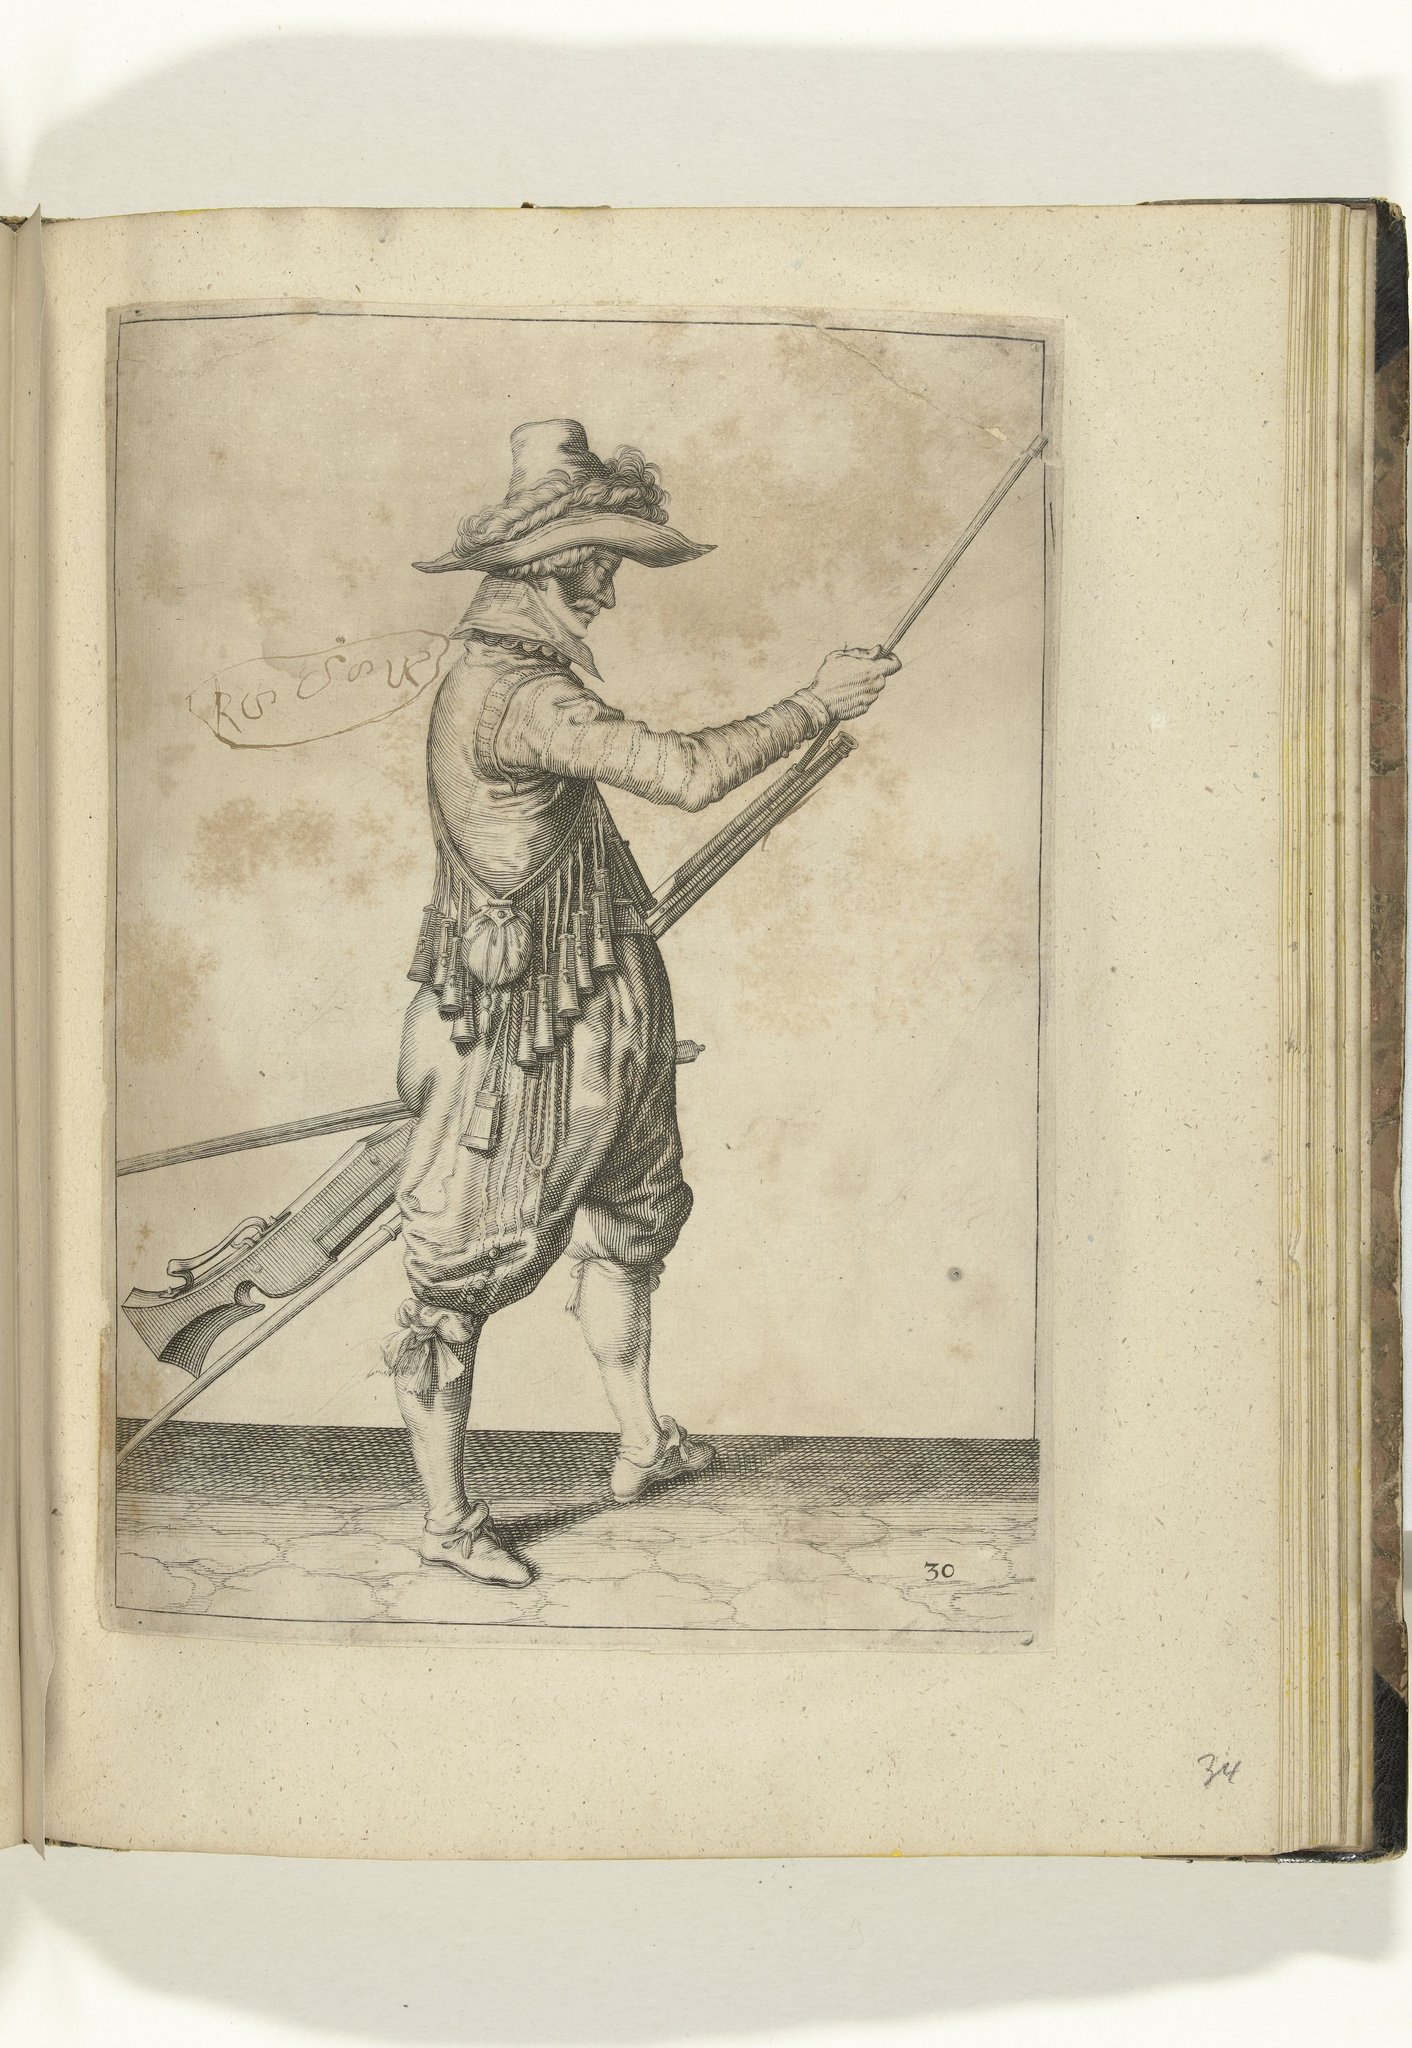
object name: print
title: Soldaat die zijn laadstok in de houder onder de loop van zijn musket schuift (nr. 30), ca. 1600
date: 1597-1608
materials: paper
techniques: engraving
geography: northern netherlands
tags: the hague, maurice (prince of orange), handling of weapons ~ military training, weapons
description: Een soldaat, ten voeten uit, naar rechts, die met zijn linkerhand bij zijn linkerdijbeen een musket (een bepaald type vuurwapen) vasthoudt en met zijn rechterhand de laadstok in de houder onder de loop schuift (nr. 30), ca. 1600. In zijn linkerhand behalve het musket ook een furket (musketvork). Plaat 30 in de instructies voor het hanteren van het musket: Shorte instruction for the figures, so much concerneth the right use of muskett. Onderdeel van de illustraties in een Engelse editie van J. de Gheyns Wapenhandelinghe: J. de Gheyn, The exercise of armes for calivres, muskettes and pikes after the ordre of Maurits Prince of Orange, 's-Gravenhage 1608. Krijgswezen rond 1600.